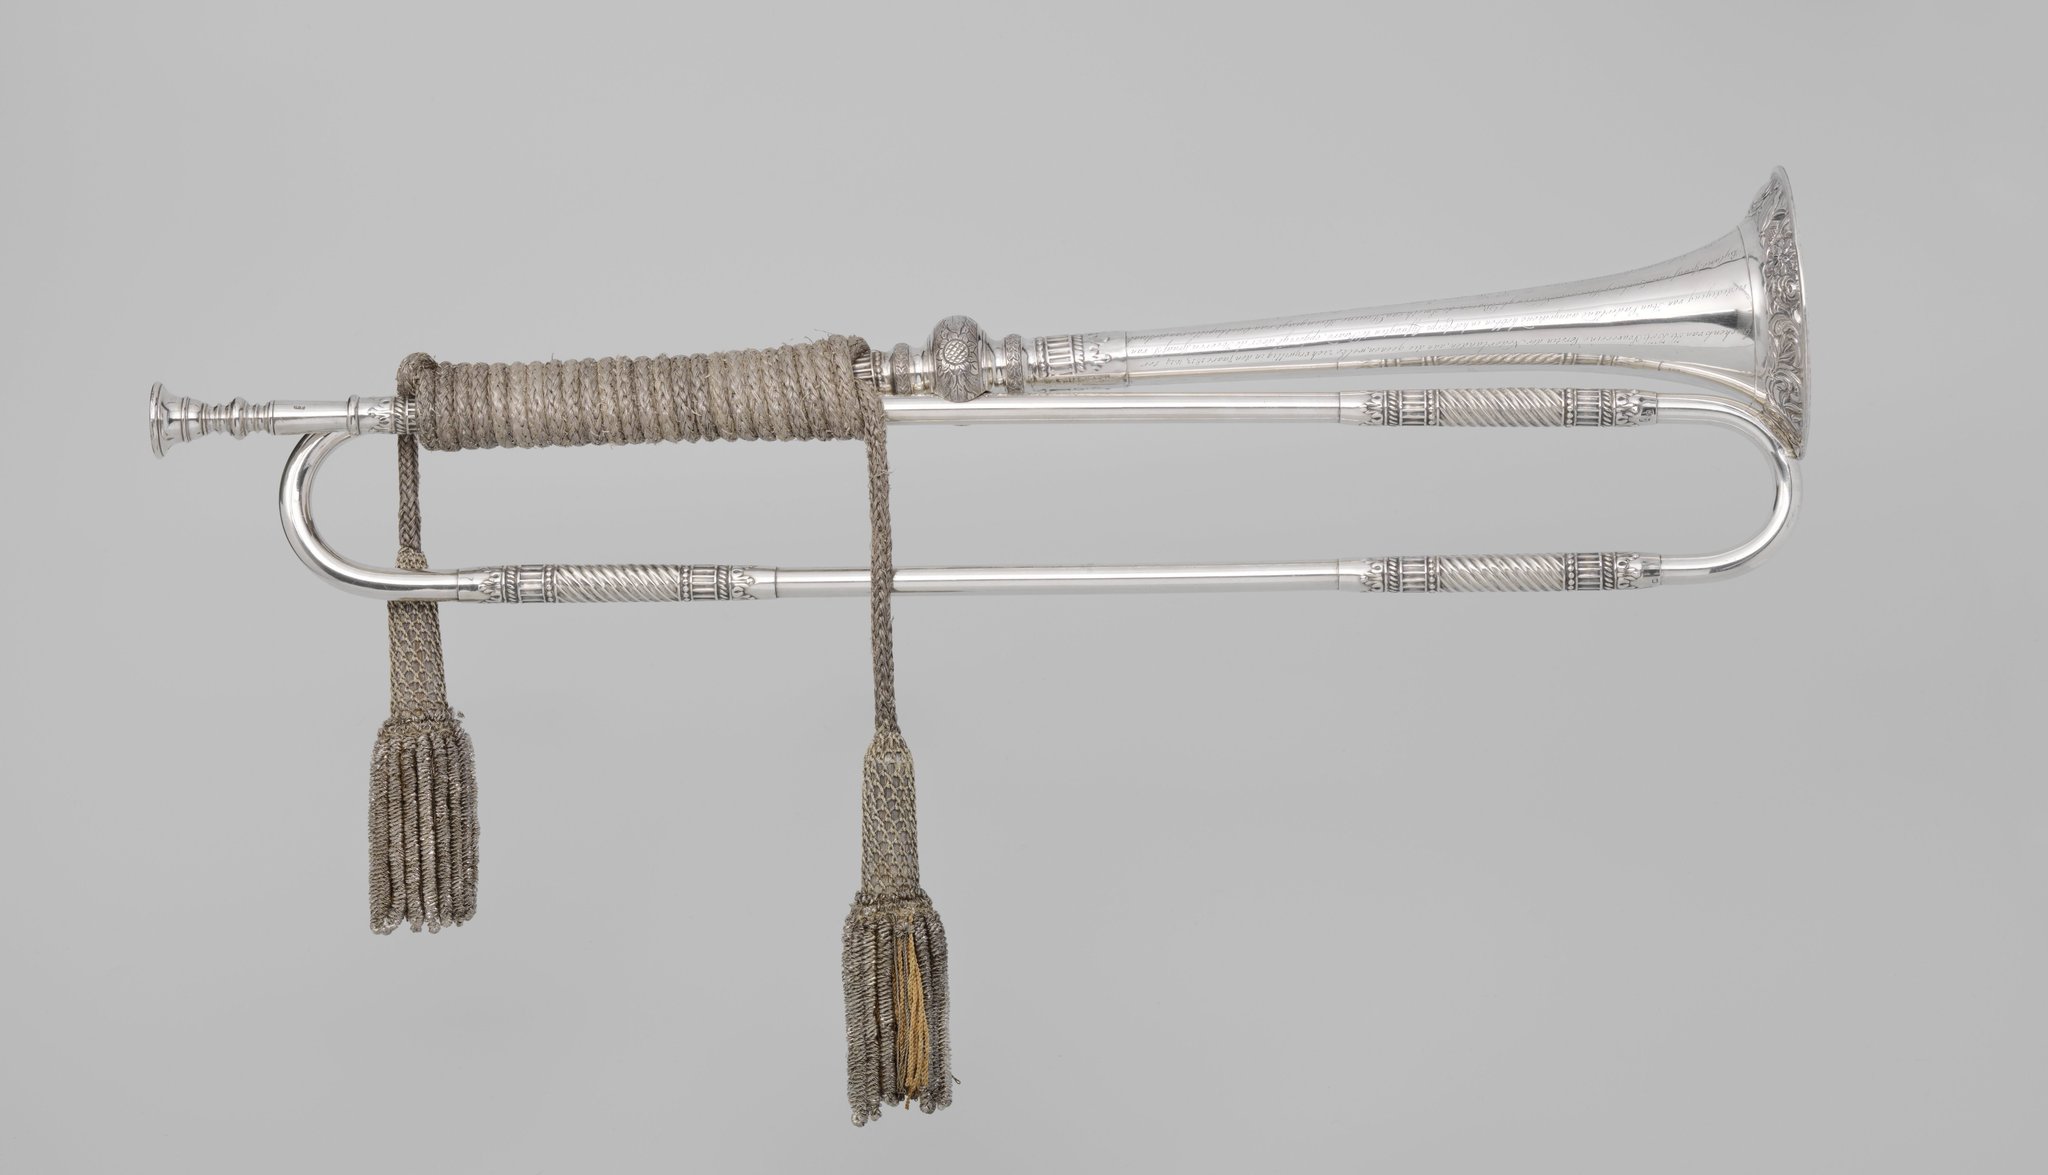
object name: musical instrument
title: Trumpet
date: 1813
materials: silver, thread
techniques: engraving, striking, turning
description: Willem I kocht deze trompet in 1813 en schonk hem aan het corps lijfwachten te paard, een elite-eenheid die Nederland had verdedigd tegen Napoleon. Hun namen staan in lange rijen gegraveerd op de beker, zoals Graaf van Limburg Stirum en Baron Desmet van Deurne. Op 26 maart 1814, kort voor Willems huldiging als souverein vorst, werd deze trompet gepresenteerd aan de voormalige lijfwachten tijdens een ceremonie op de Dam. Rondom de beker is een smalle band met gegraveerde plant- en bloemmotieven en trommels en trompetten. Op de verdikking vóór de handgreep eveneens een versiering met gegraveerde plant- en bloemmotieven. De vier flenzen gegraveerd met eenvoudige lijnmotieven. Gesigneerd: W. T. (William Troby). Gemerkt: lopende leeuw, wapenschildje, jaarletter (onleesbaar) bovenzijde tromp. Op de buis: 'W. SANDBACH'.